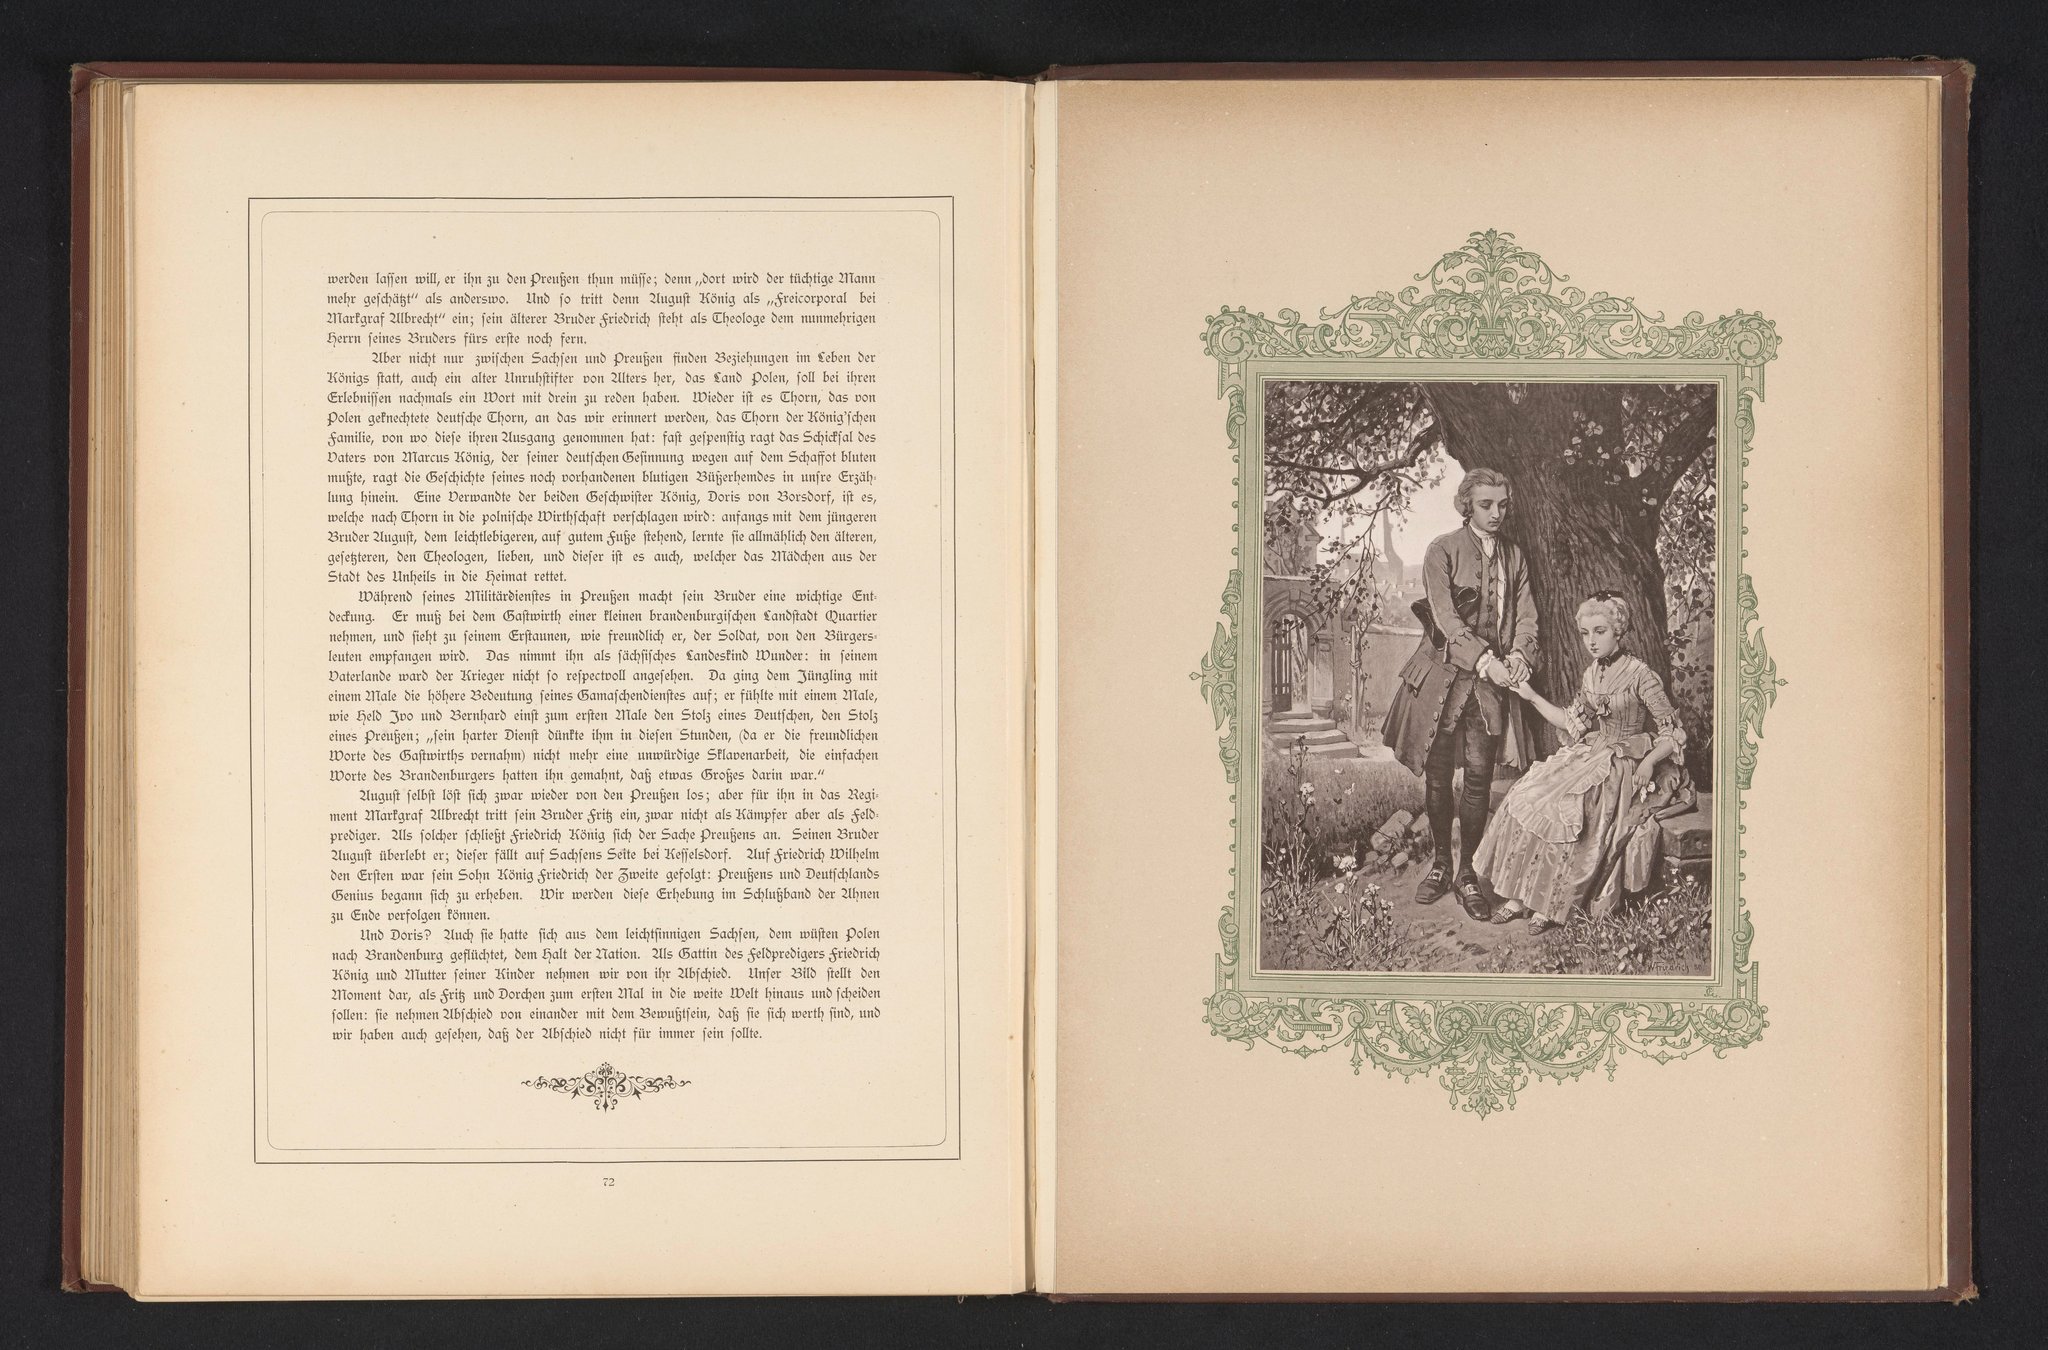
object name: photomechanical print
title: Fotoreproductie van een schilderij voorstellende een scene met Fritz en Dorchen in een tuin uit Die Ahnen door Gustav Freytag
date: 1880-1882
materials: paper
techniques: photograph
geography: germany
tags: garden, couple of lovers